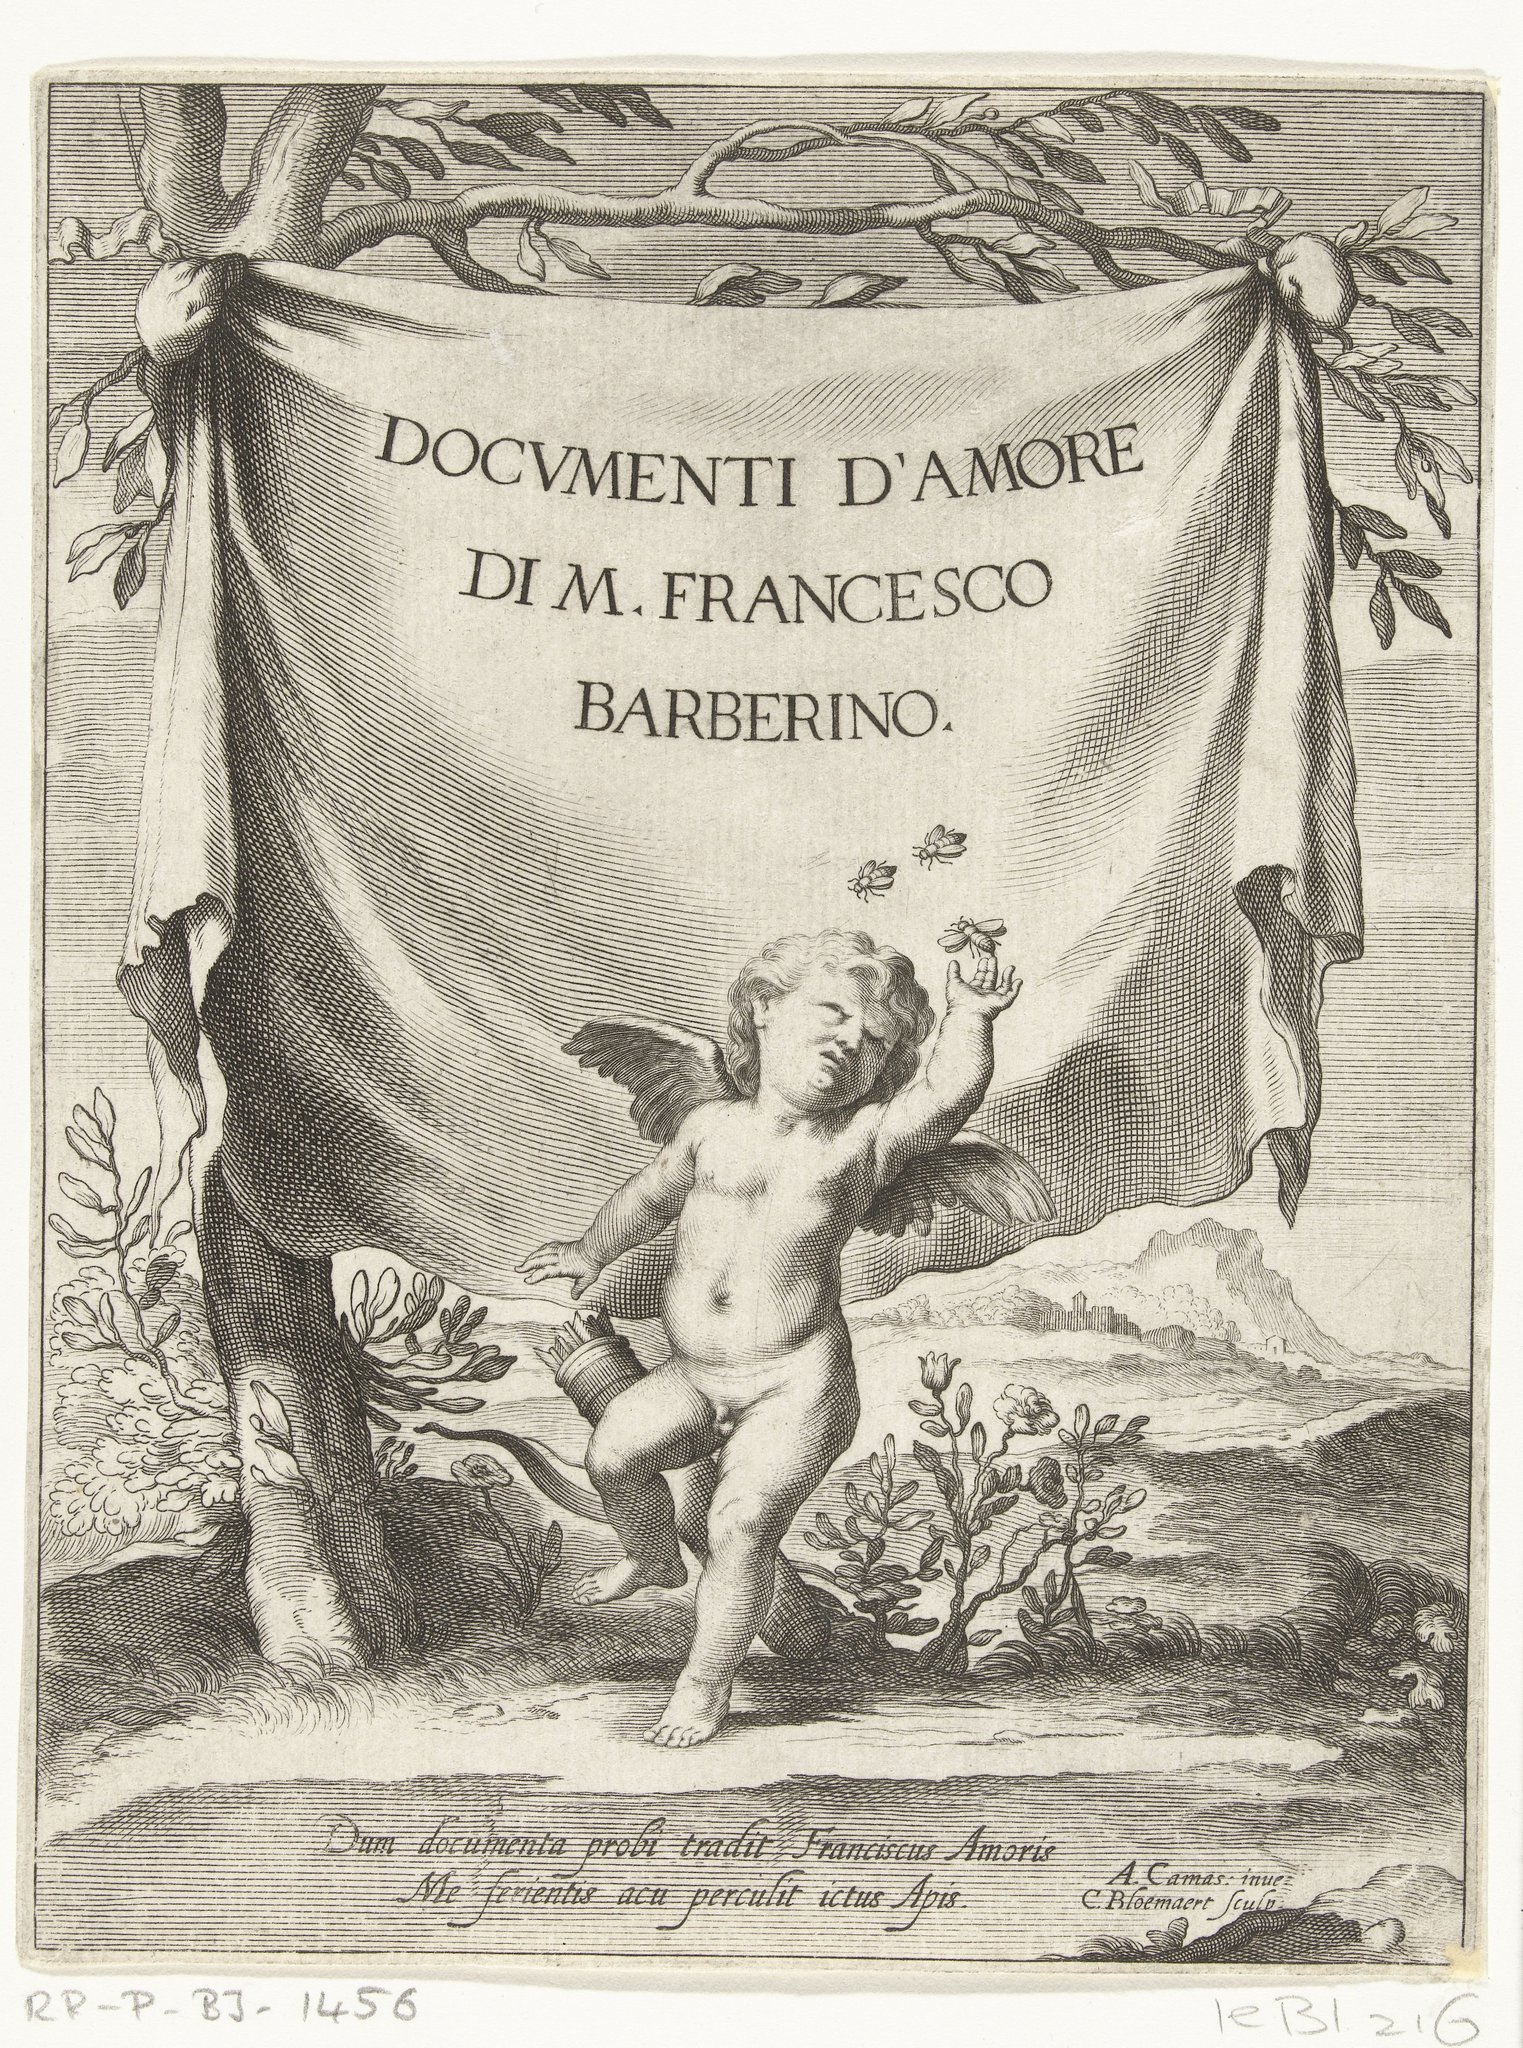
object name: print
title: Amor probeert bijen te vangen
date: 1640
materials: paper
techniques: engraving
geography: rome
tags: title-page, non-aggressive, friendly or neutral activities and relationships of cupid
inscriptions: collector's mark: Lugt 2228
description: Amor is bezig om bijen te vangen. Huppelend op een been strekt hij zijn hand uit naar de dieren. Achter hem aan een tak van een boom hangt een groot doek met de titel van het boek.